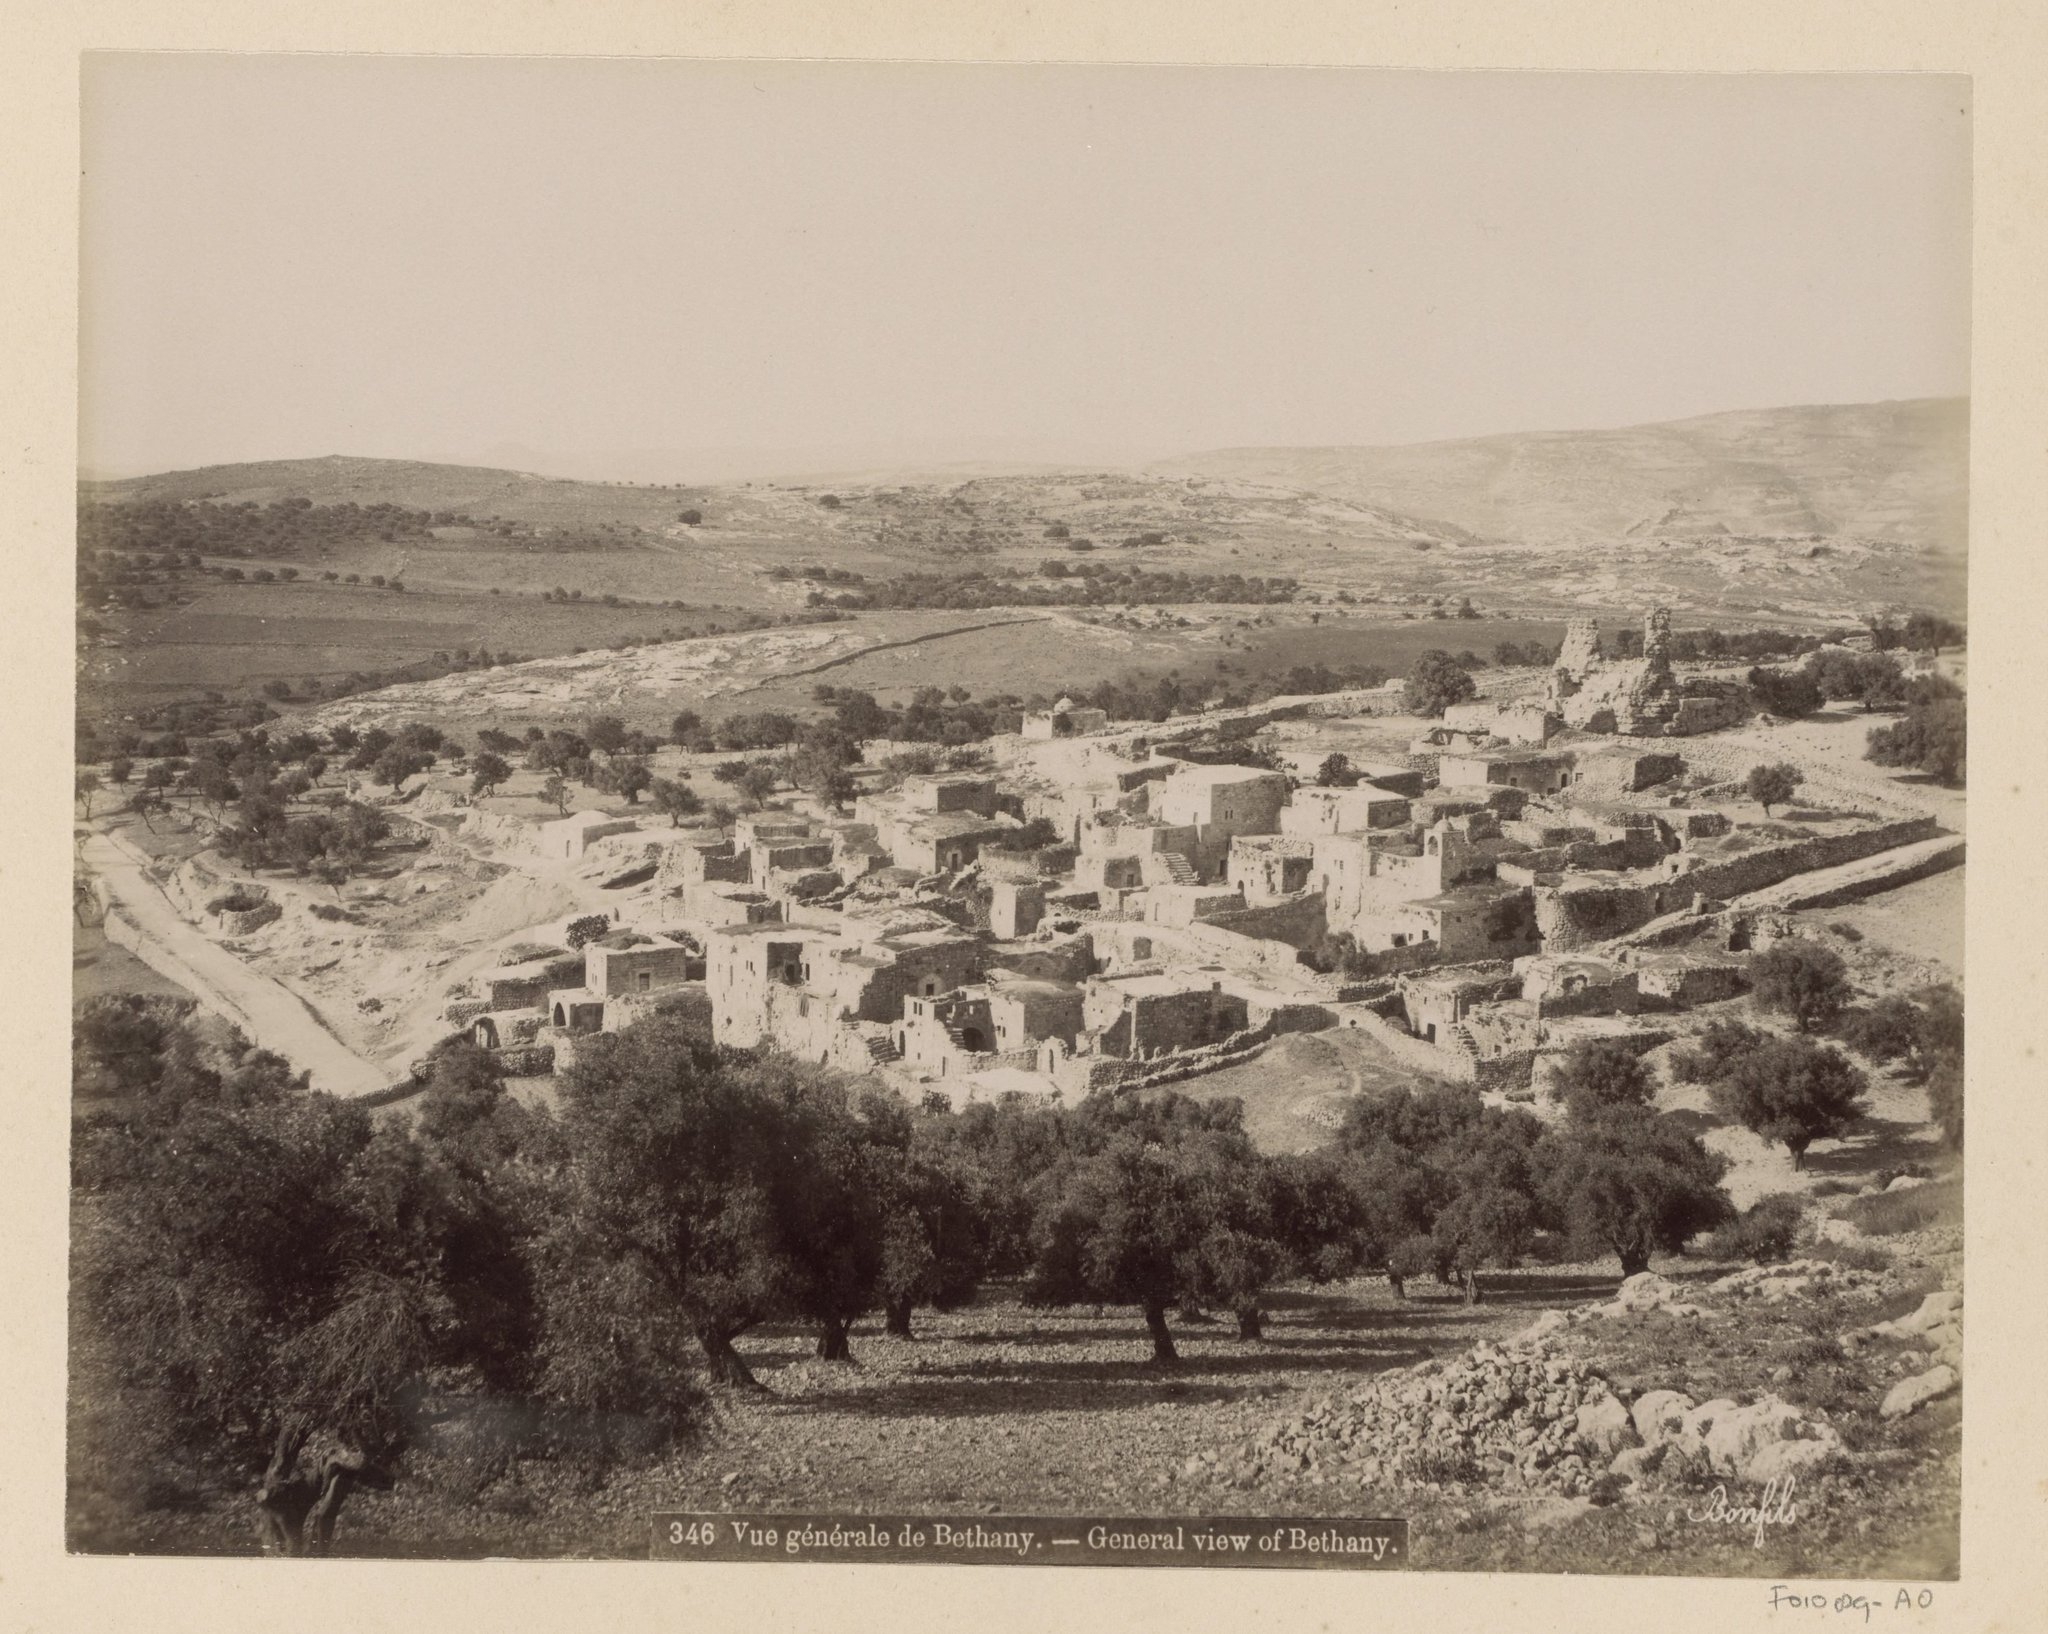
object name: photograph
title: Vue générale de Bethany.- General view of Bethany.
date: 1867-1895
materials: cardboard, paper, photographic support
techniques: albumen print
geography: bethanie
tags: prospect of village, silhouette of village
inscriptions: negative number: ‘346’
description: Onderdeel van Reisalbum met foto's van Jeruzalem en andere bijbelse plaatsen.